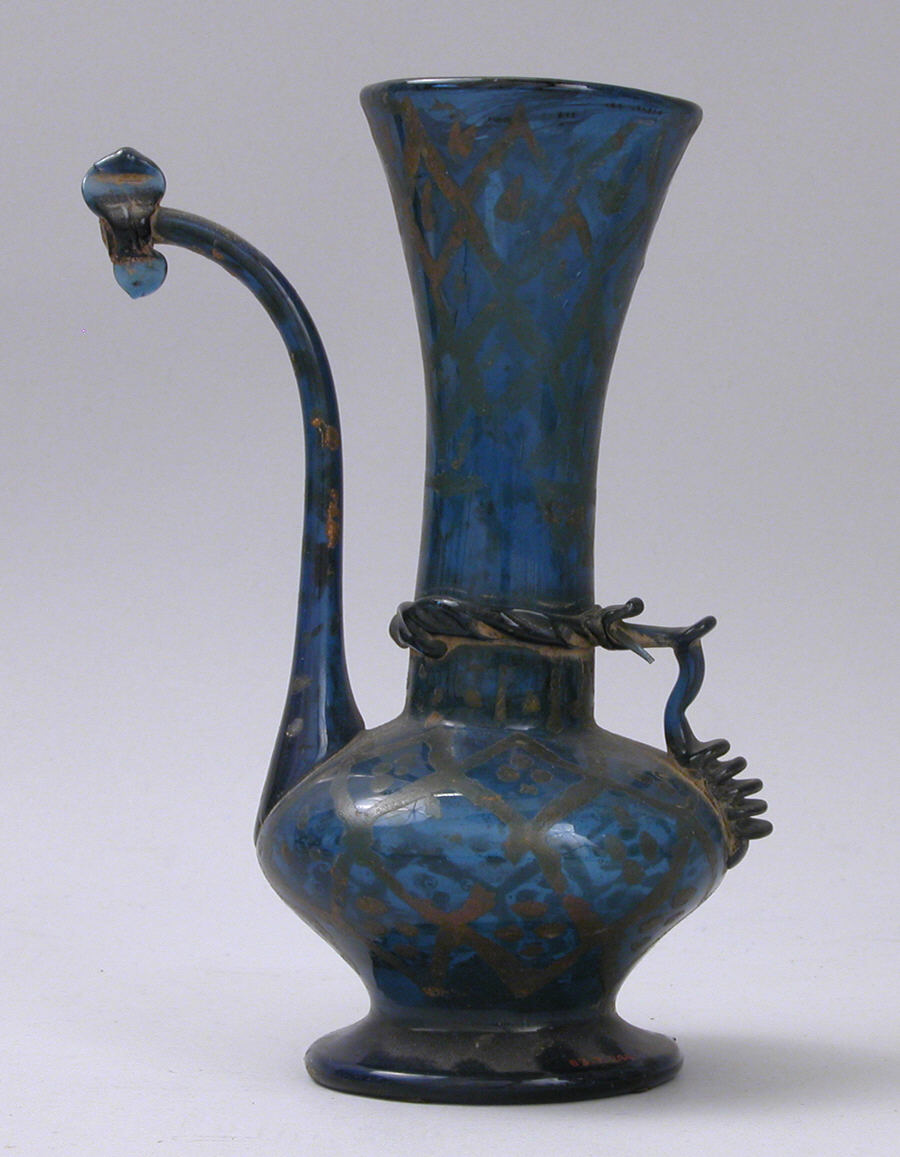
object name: ewer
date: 1701-1900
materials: glass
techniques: glassblowing, painting, tooling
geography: iran